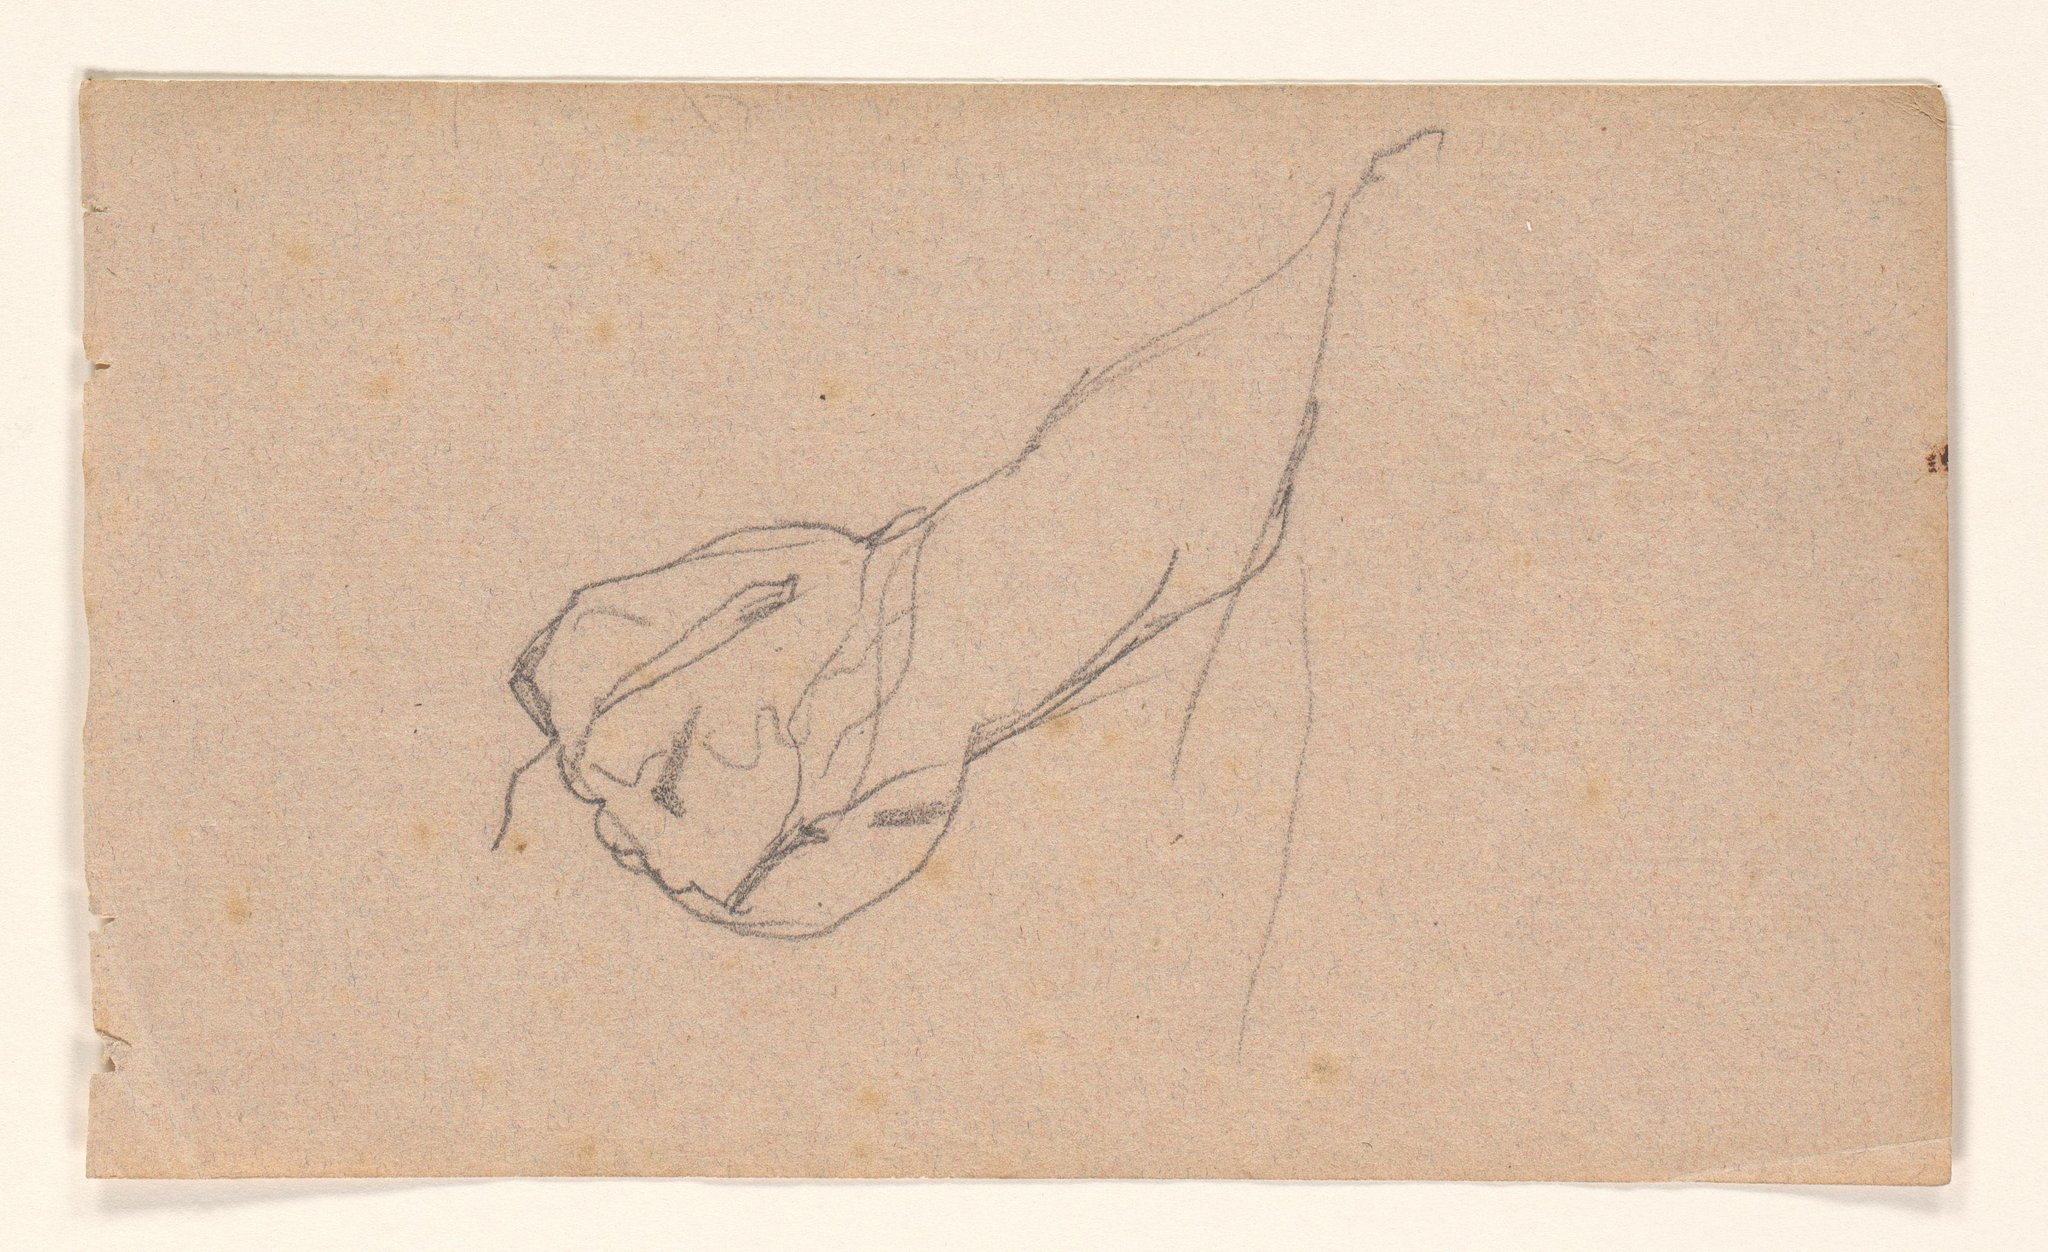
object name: drawing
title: Studie van een hand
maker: august allebé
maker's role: draughtsman, print maker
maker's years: 1838-1927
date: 1848-1927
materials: paper, pencil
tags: hand